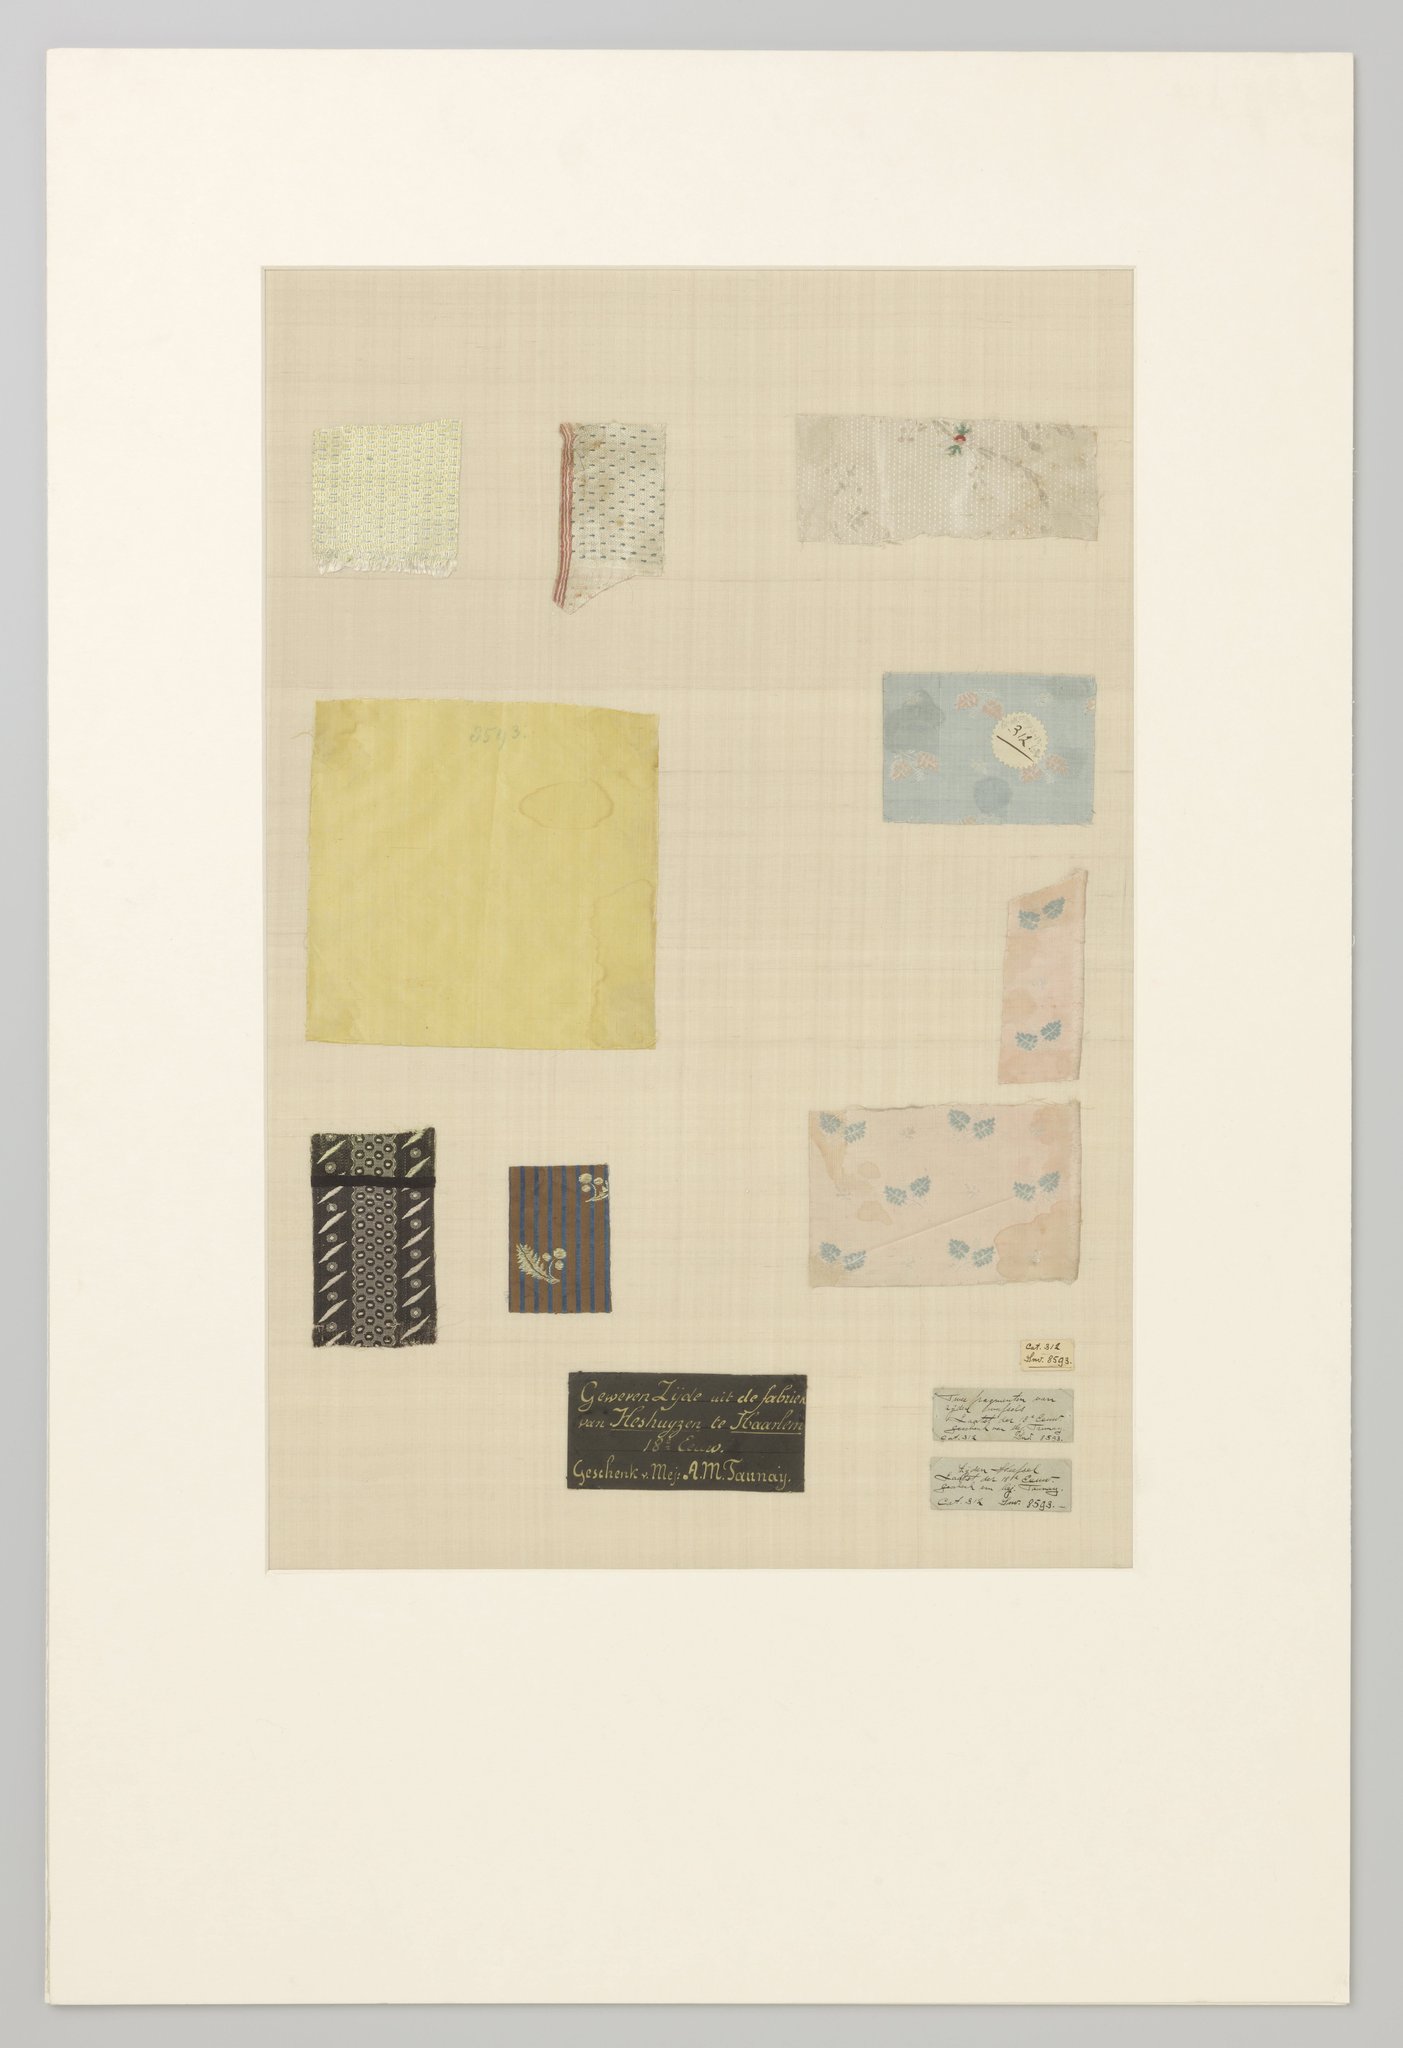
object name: fragment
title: Fragment zijdeweefsel.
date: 1750-1800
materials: silk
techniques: brocade, weave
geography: haarlem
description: Fragment zijdeweefsel. Een lichtblauwe grond heeft een patroon van rijen met dubbele roze bladeren op een witte steel, waartussen een kleine witte tak.